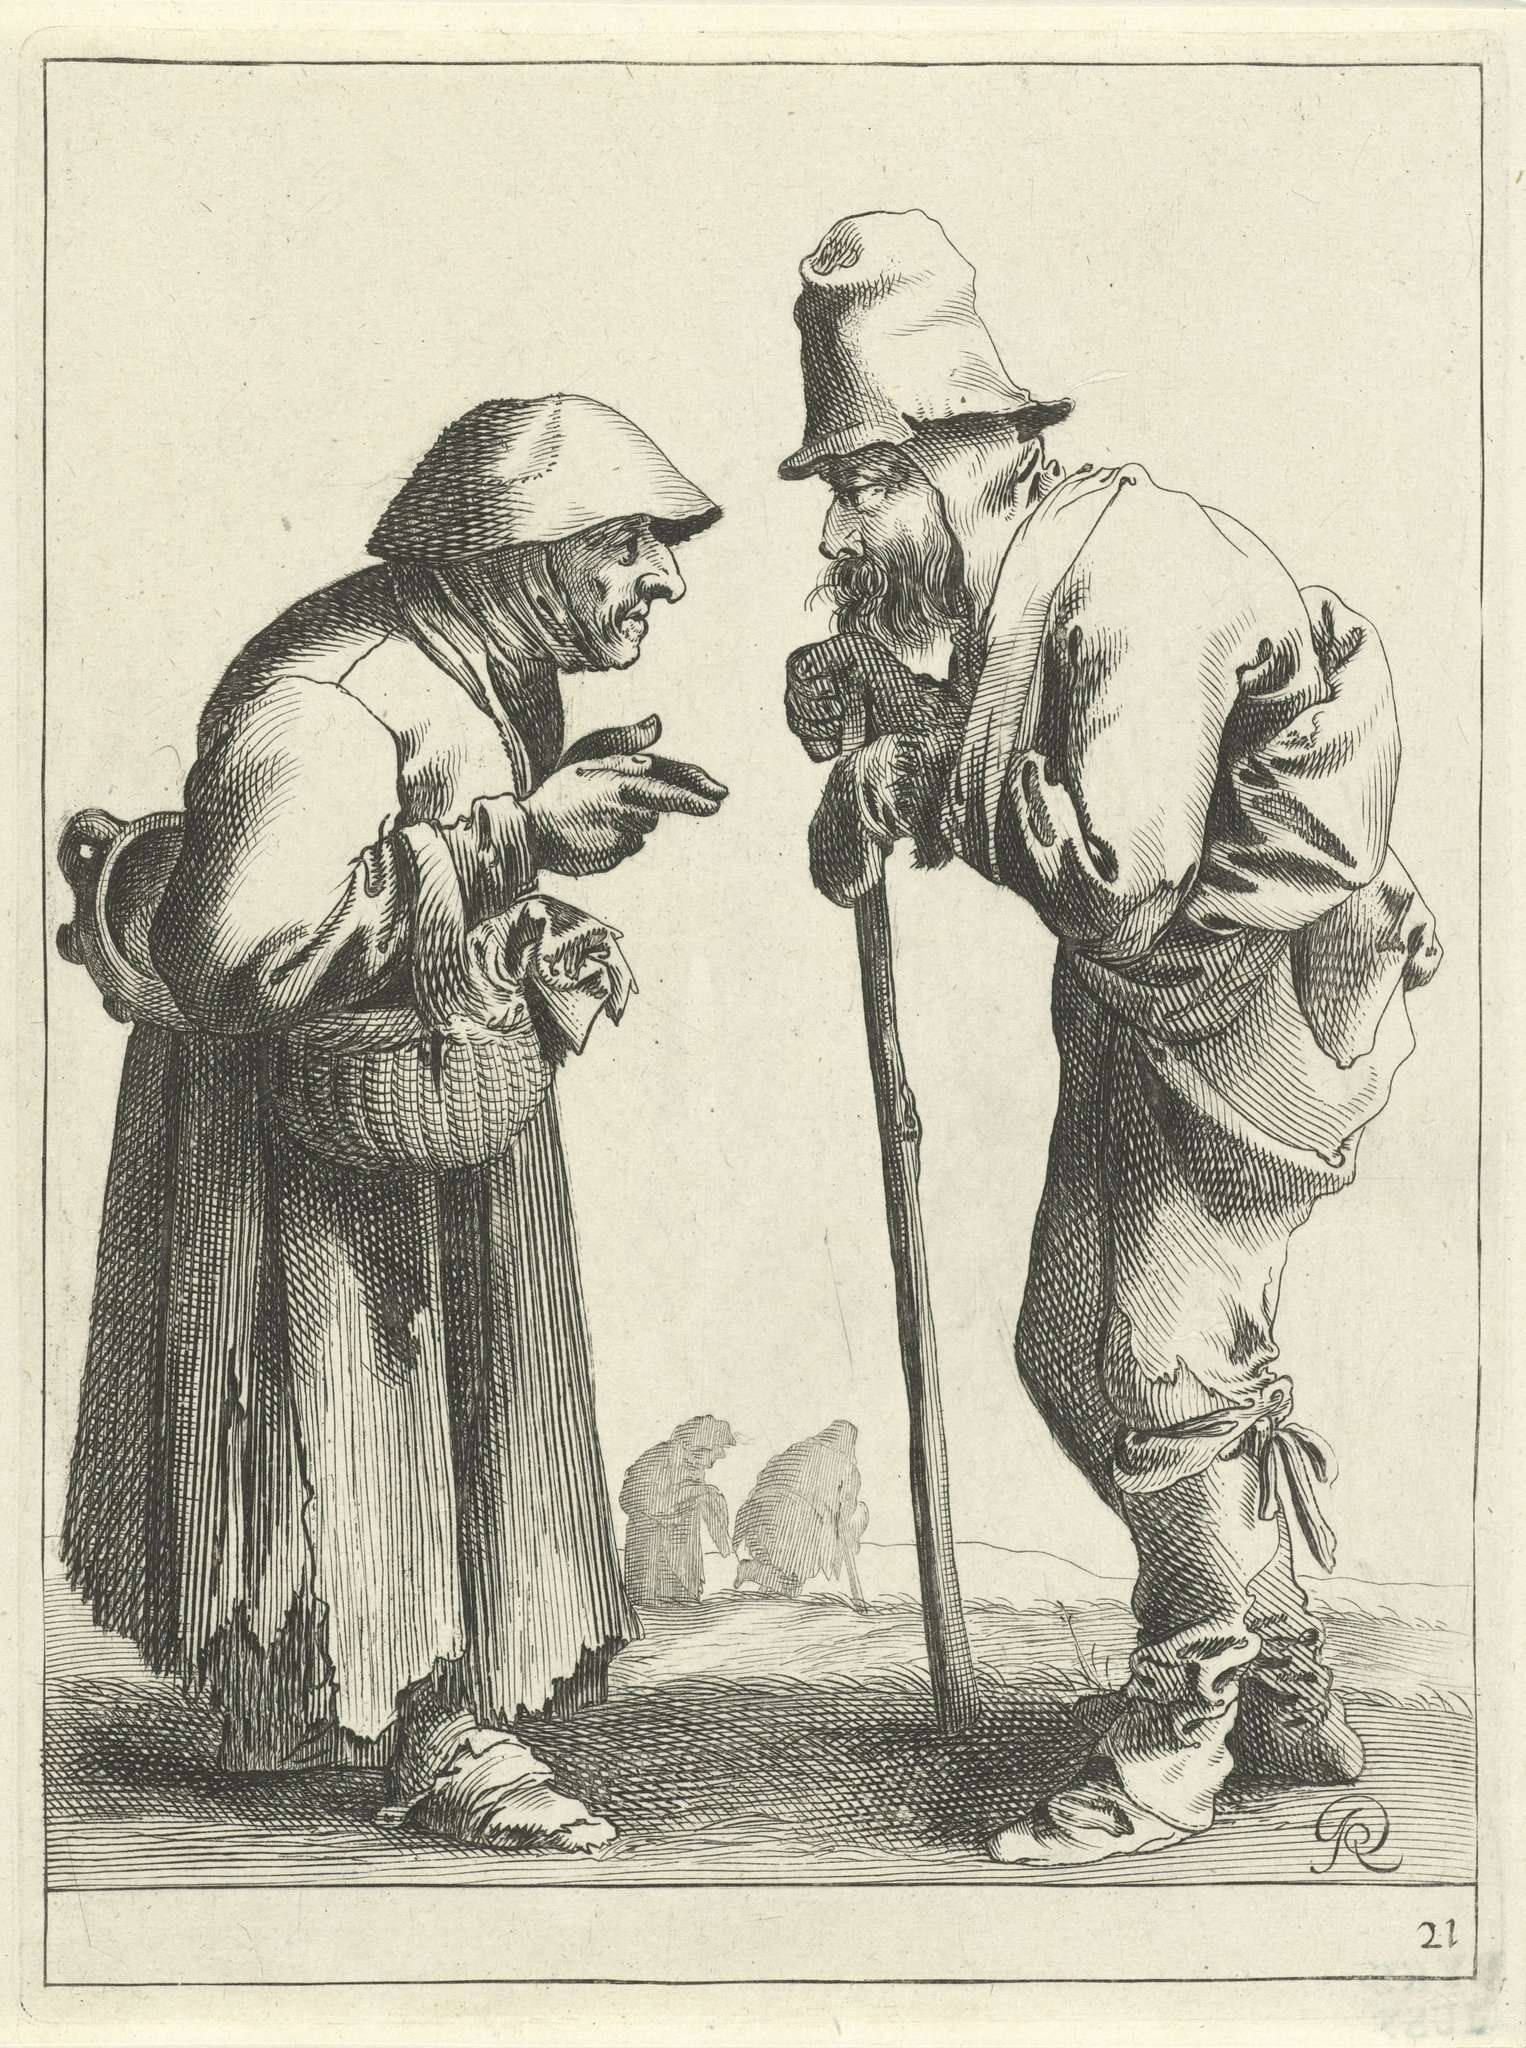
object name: print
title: Bedelaars en boeren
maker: pieter jansz quast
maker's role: draughtsman, painter, print maker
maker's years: 1605-1647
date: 1634-1638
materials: paper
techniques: engraving, etching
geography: the hague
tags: walking-stick, staff, container made of plant material other than wood: basket, conversation, dialogue; conversation piece, beggar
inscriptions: collector's mark: Lugt 2165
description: Een bedelaarster, met een mand om haar arm, is in gesprek met een bedelaar die op een stok leunt. Op de achtergrond twee landlopers. De prent maakt deel uit van een serie van zesentwintig prenten met bedelaars en boeren.